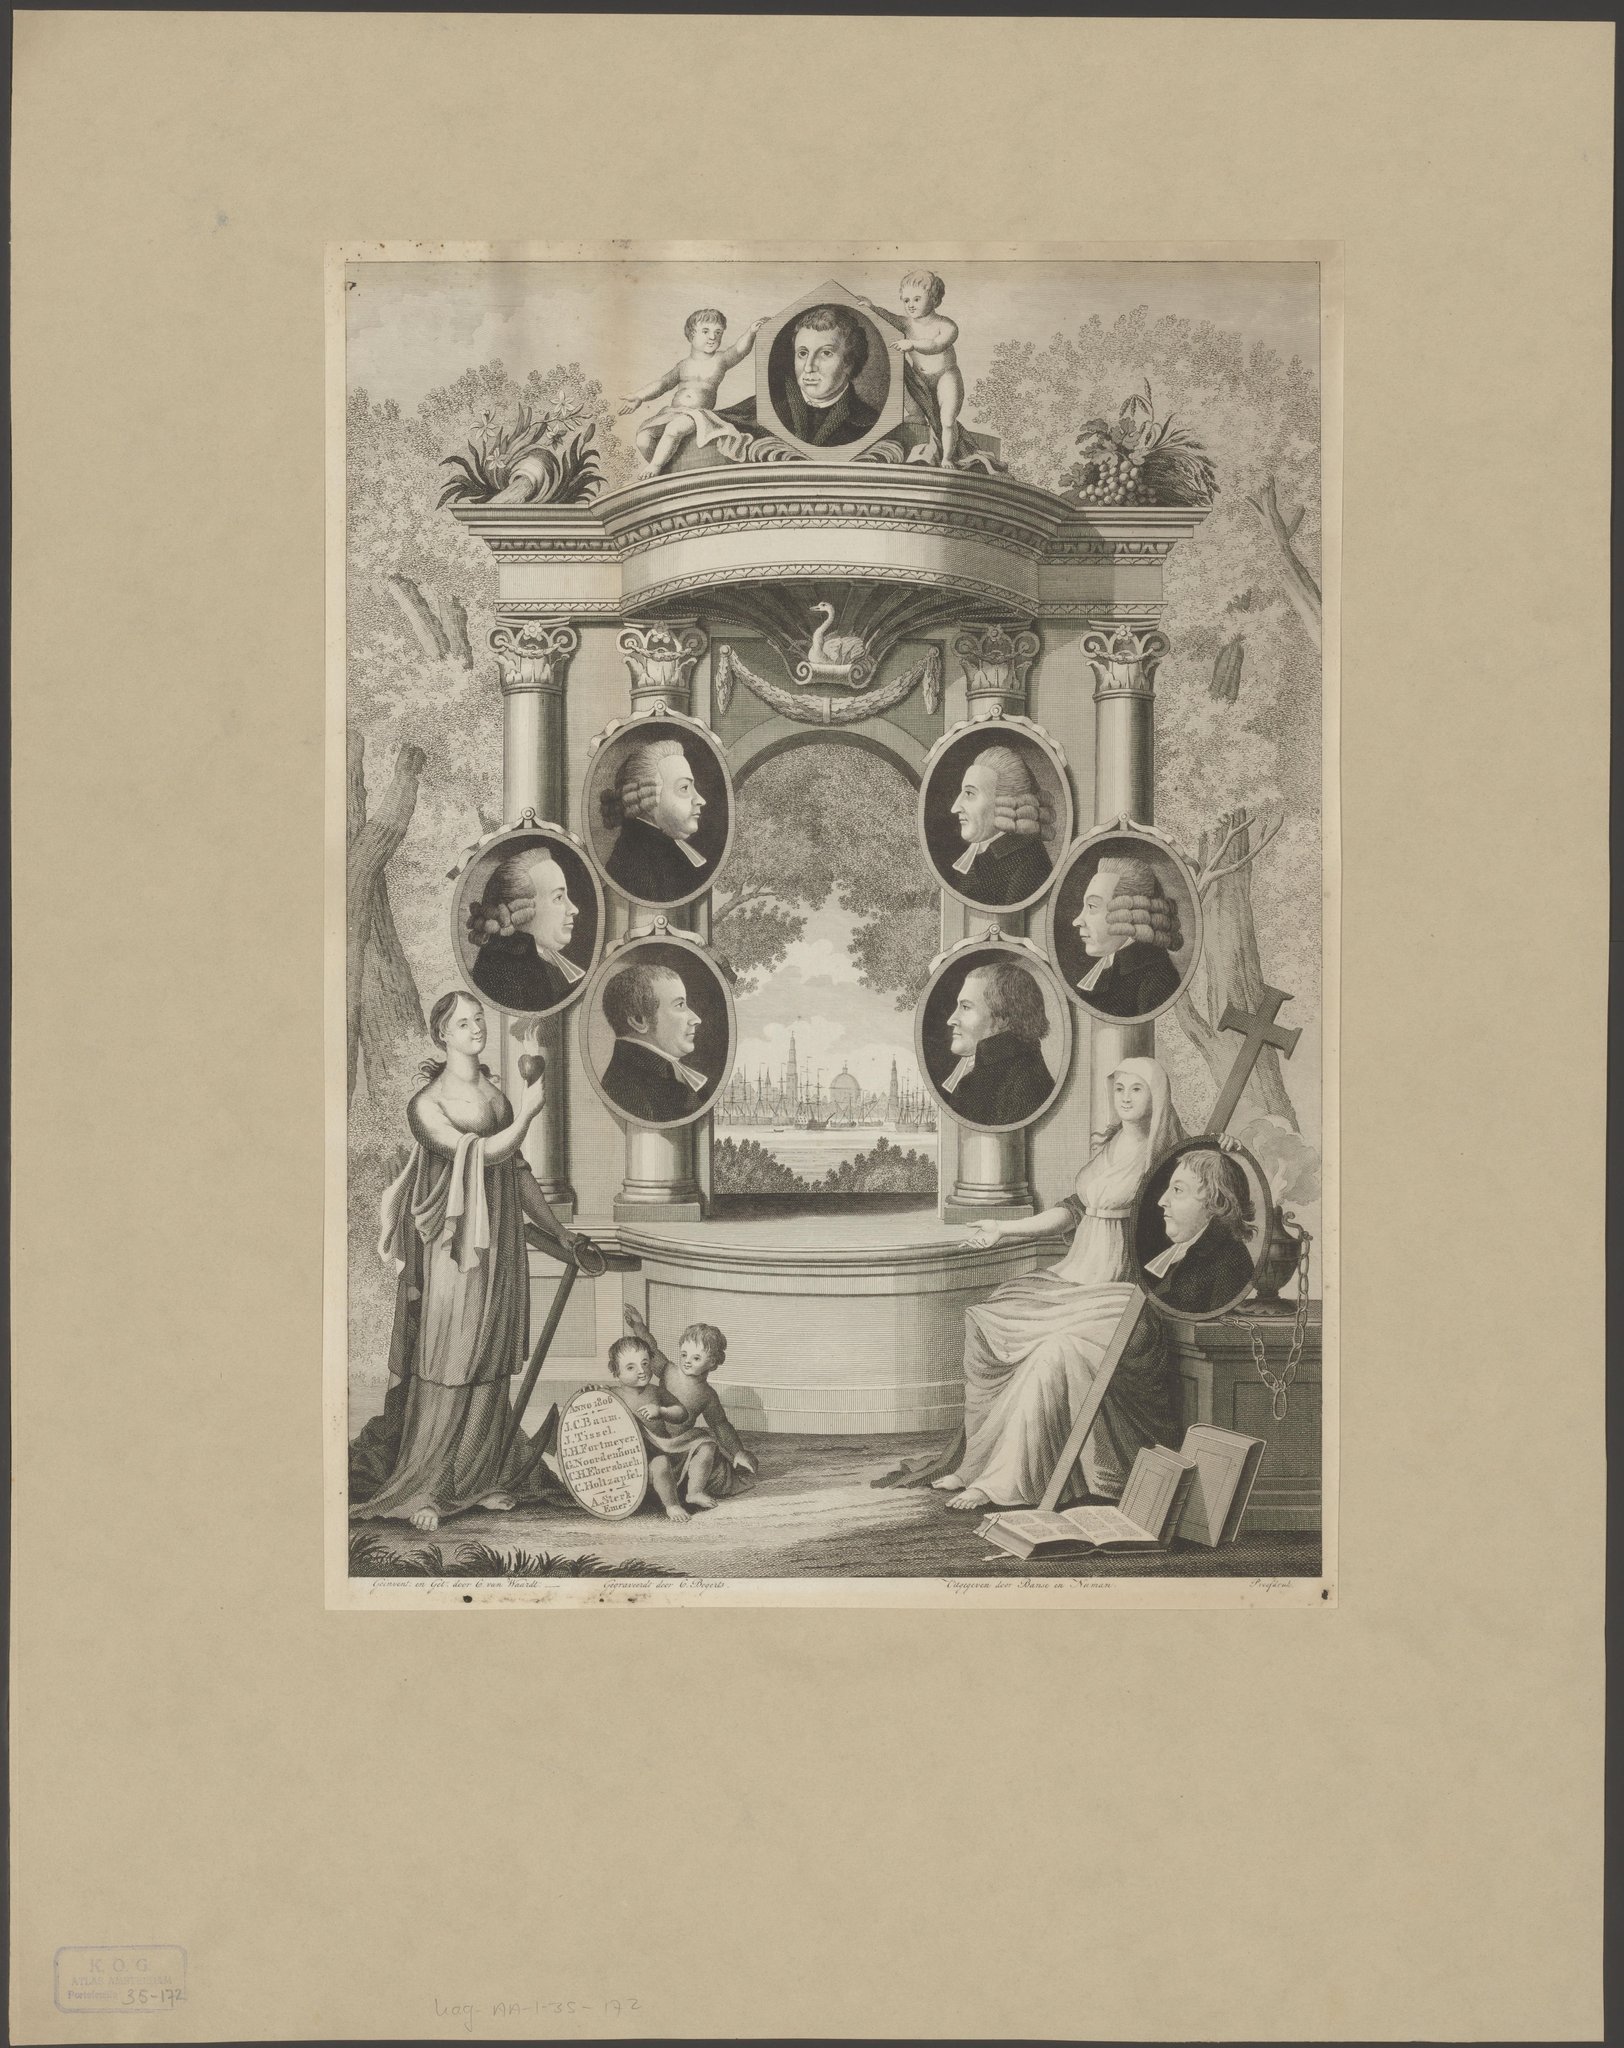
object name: print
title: Lutherse predikanten te Amsterdam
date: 1806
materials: paper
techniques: etching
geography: amsterdam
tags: christiaan van waardt, leiden, germany, amsterdam, haarlem, priest, martin luther, faith, 'fides'; 'fede', 'fede catholica', 'fede christiana', 'fede christiana catholica' (ripa) ~ one of the three theological virtues, hope, 'spes'; 'speranza divina e certa' (ripa) ~ one of the three theological virtues, water-birds: swan, historical persons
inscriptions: collector's mark: Lugt 1641b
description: Allegorische voorstelling met een erepoort met uitzicht op de stad Amsterdam en de Lutherse Nieuwe Kerk. Boven op de poort staat een portret van Marten Luther. Eronder is een zwaan afgebeeld, het symbool van de Lutherse kerk in Nederland. Aan de poort hangen portretten van zes Amsterdamse Lutherse predikanten (links, van boven af: J.C. Baum, J.H. Fortmeijer en C.H. Eberbach, rechts, van boven af: J. Tissel, G. Noordenhout en C. Holtzapffel). Voor de poort staan Hoop, met brandend hart en anker, en Geloof. Geloof houdt een zevende portret vast, van Augustus Sterk, een befaamd predikant, maar sinds 1802 op emeritaat. Onderwerpsrubriek binnen de Atlas Amsterdam: Kerkwezen: Ev. Lutherse Gemeente: Predikanten.